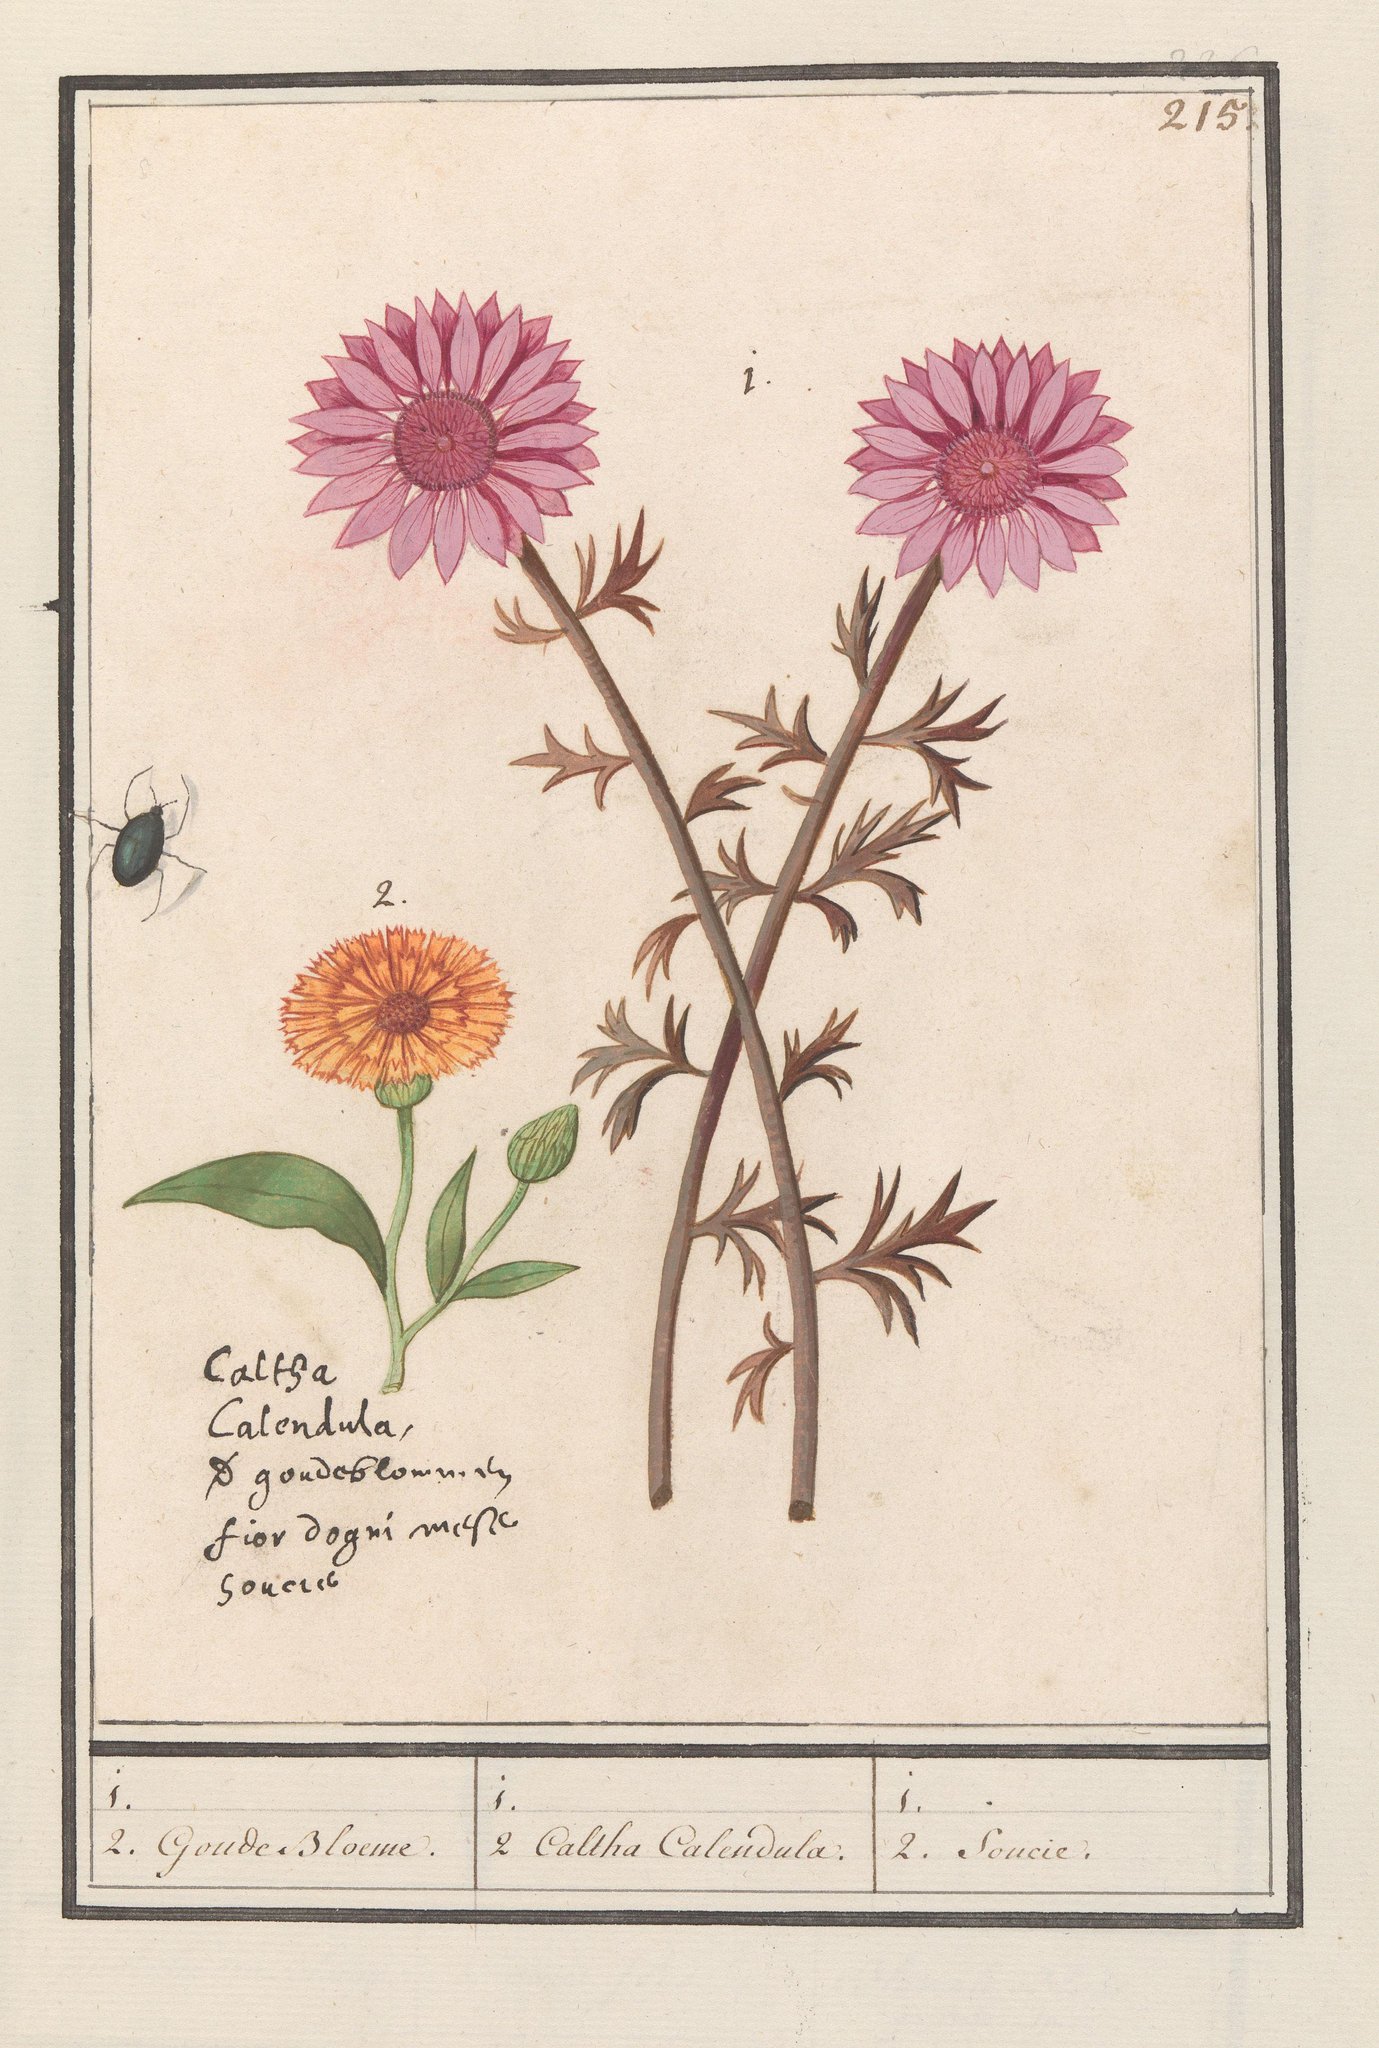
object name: drawing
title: Pink Flower (unknown) and Marigold (Calendula officinalis)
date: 1596-1610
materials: chalk, paint, ink, paper, watercolor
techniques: brush, pen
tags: flowers: anemone, flowers: calendula, insects: beetle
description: In the early 19th century, the mayor of Bruges, Van Huerne, had the Historia Naturalis rebound. The drawings were pasted onto pages provided with framing lines along with the name of each living thing and species inscribed in the Dutch, Latin and French forms of the time. Although it was apparently assumed that number 1 would be identified, this line remained blank. We still do not know which flower is depicted here.